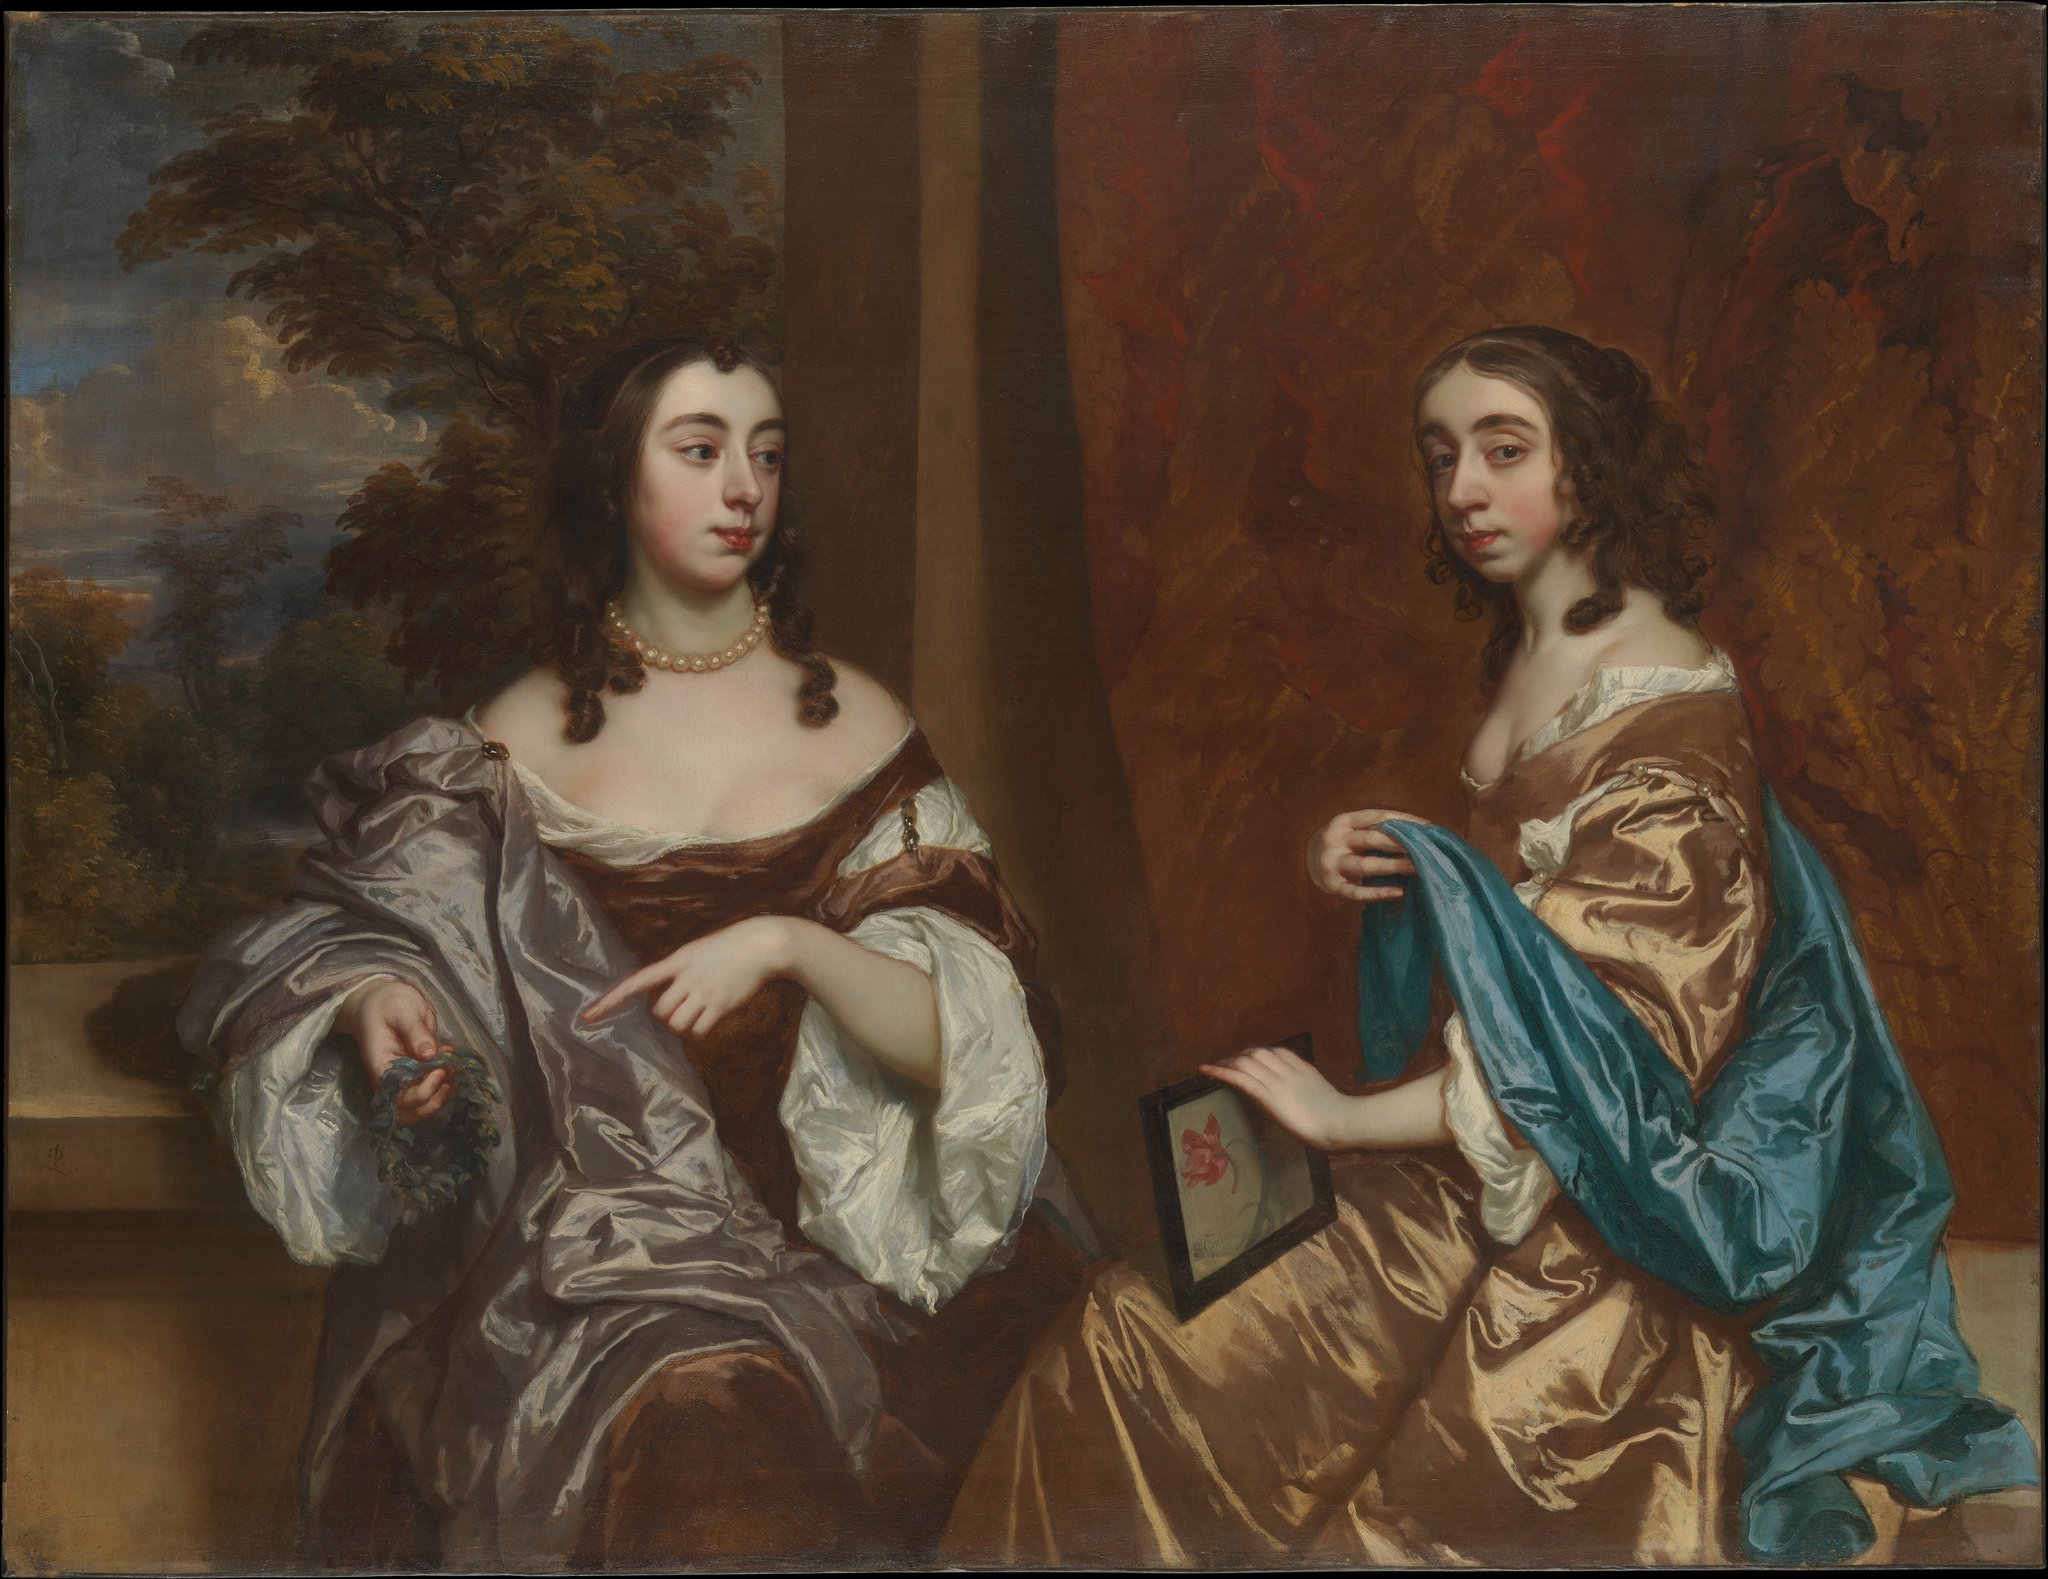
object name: painting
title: Mary Capel (1630–1715), Later Duchess of Beaufort, and Her Sister Elizabeth (1633–1678), Countess of Carnarvon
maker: peter lely (sir)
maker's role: artist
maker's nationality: dutch, british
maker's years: 1618-1680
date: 1652-1662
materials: canvas, oil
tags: portraits,women